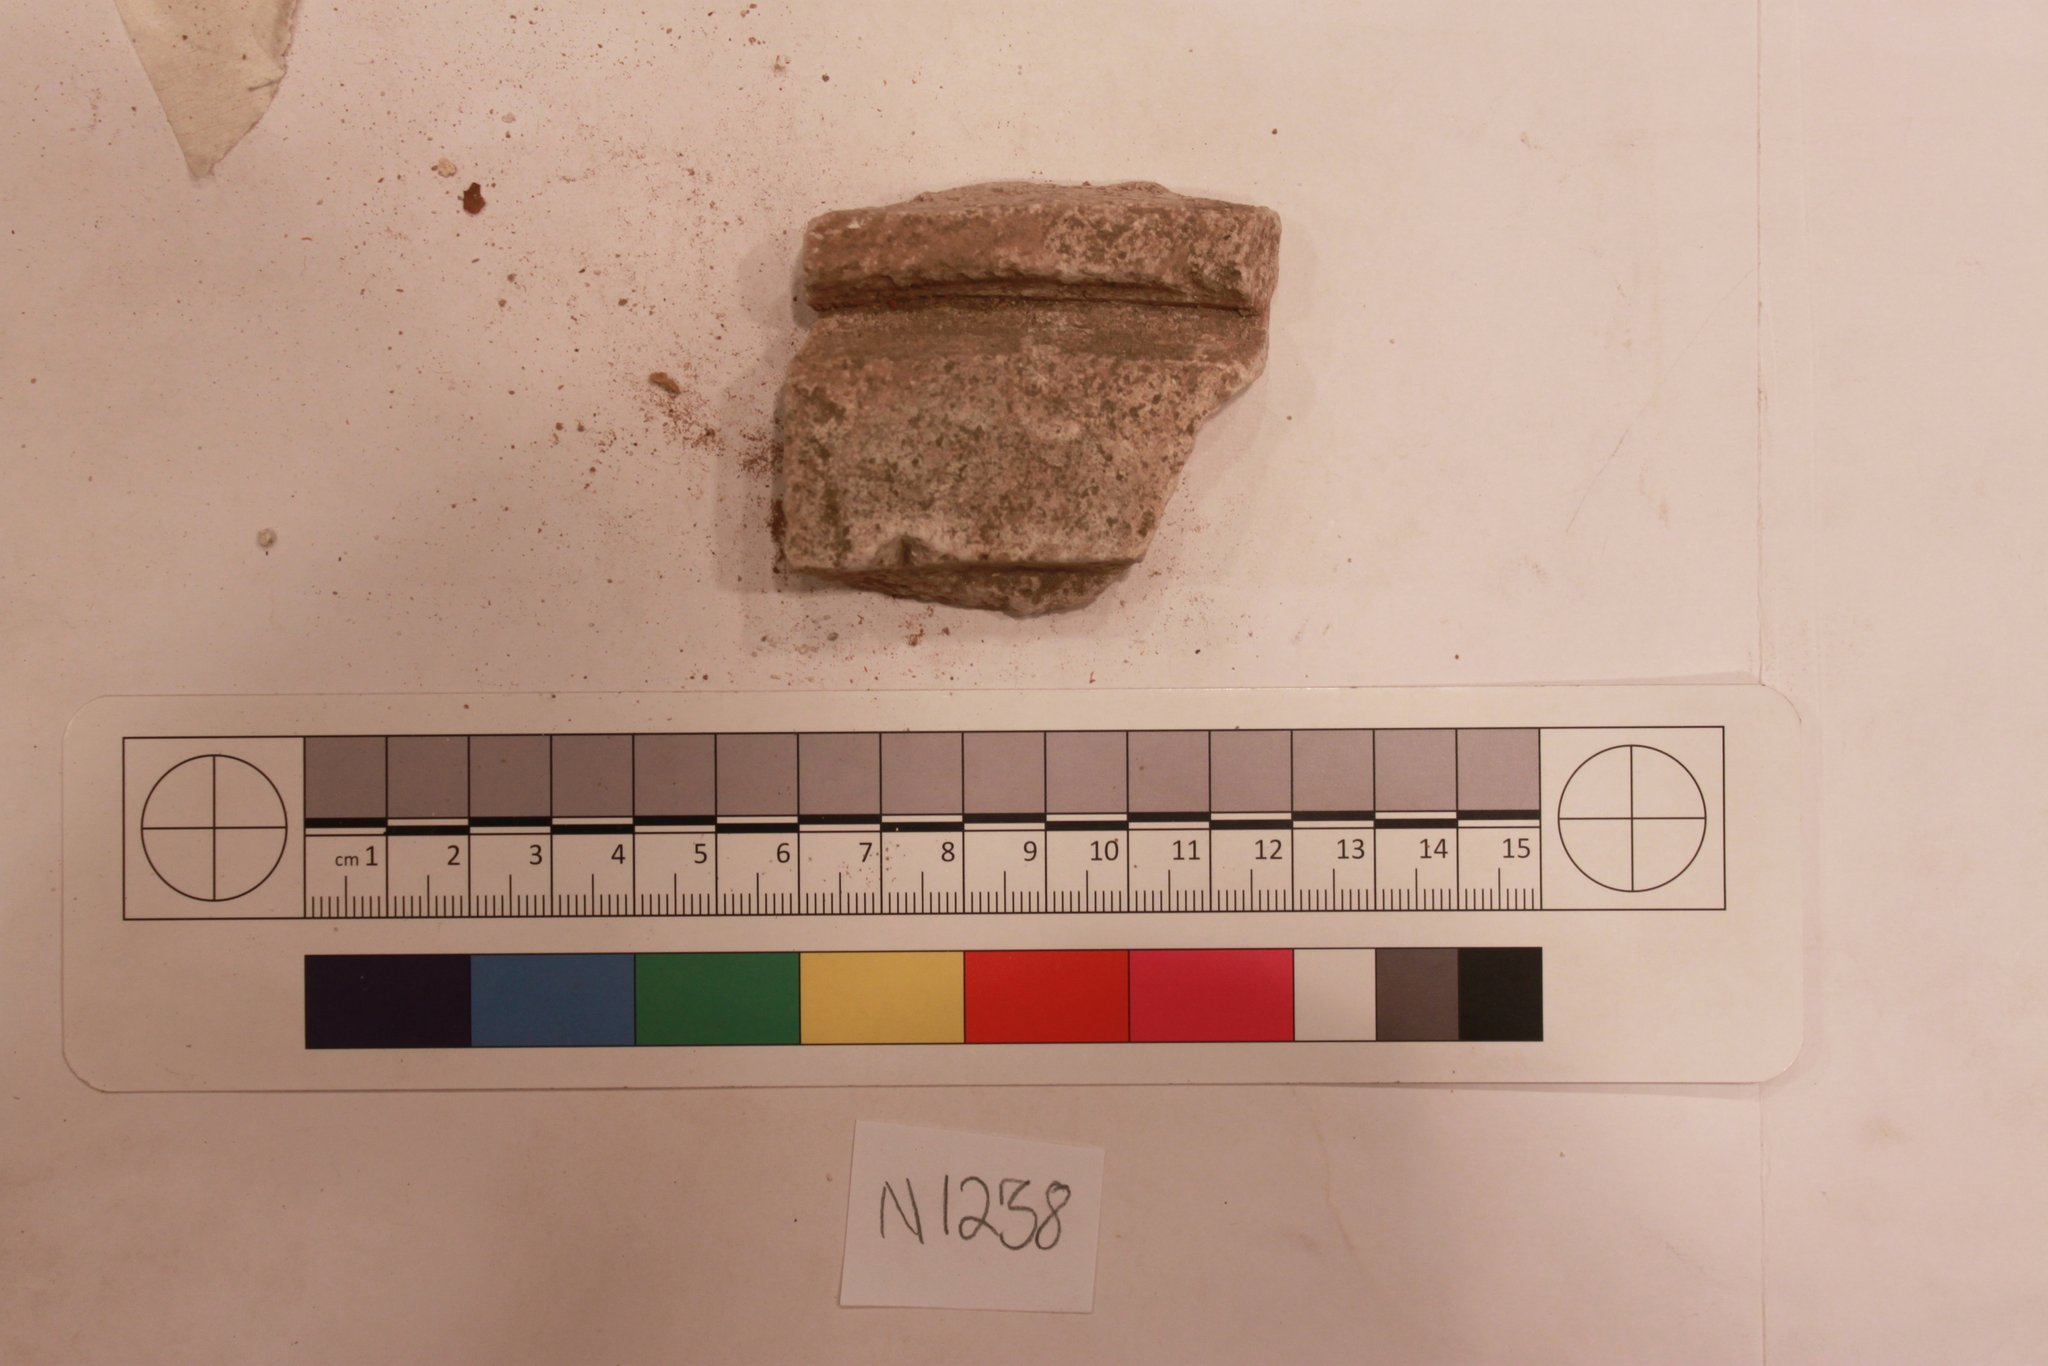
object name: fragment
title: Stucco Fragment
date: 701-1200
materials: plaster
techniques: carving, painting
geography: iran